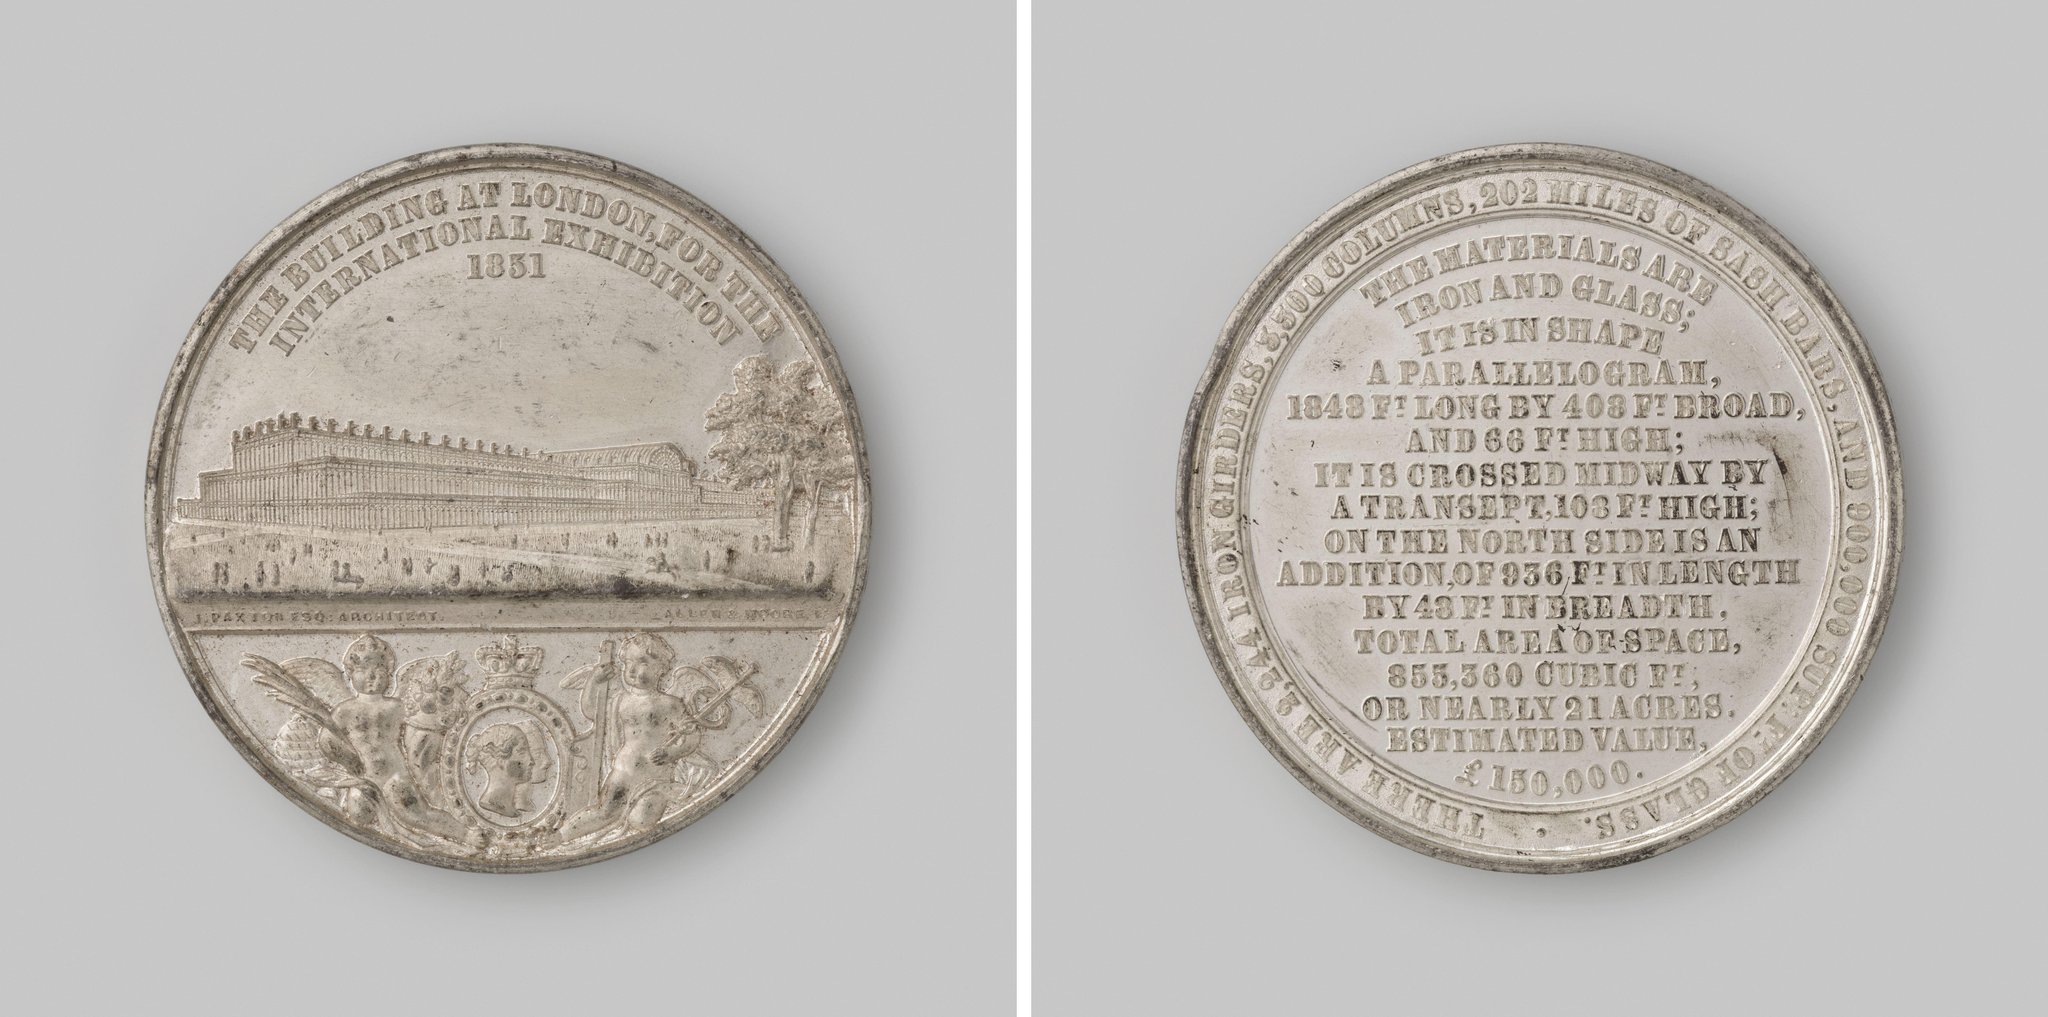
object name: history medal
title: Opening van het gebouw voor de Internationale Tentoonstelling te Londen 1851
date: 1851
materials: tin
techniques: striking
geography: birmingham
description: Tinnen penning, op de voorzijde drie regels tekst, het tentoonstellingsgebouw en een gekroond portretmedaillon tussen twee putti, op de keerzijde zestien regels tekst met omschrift.